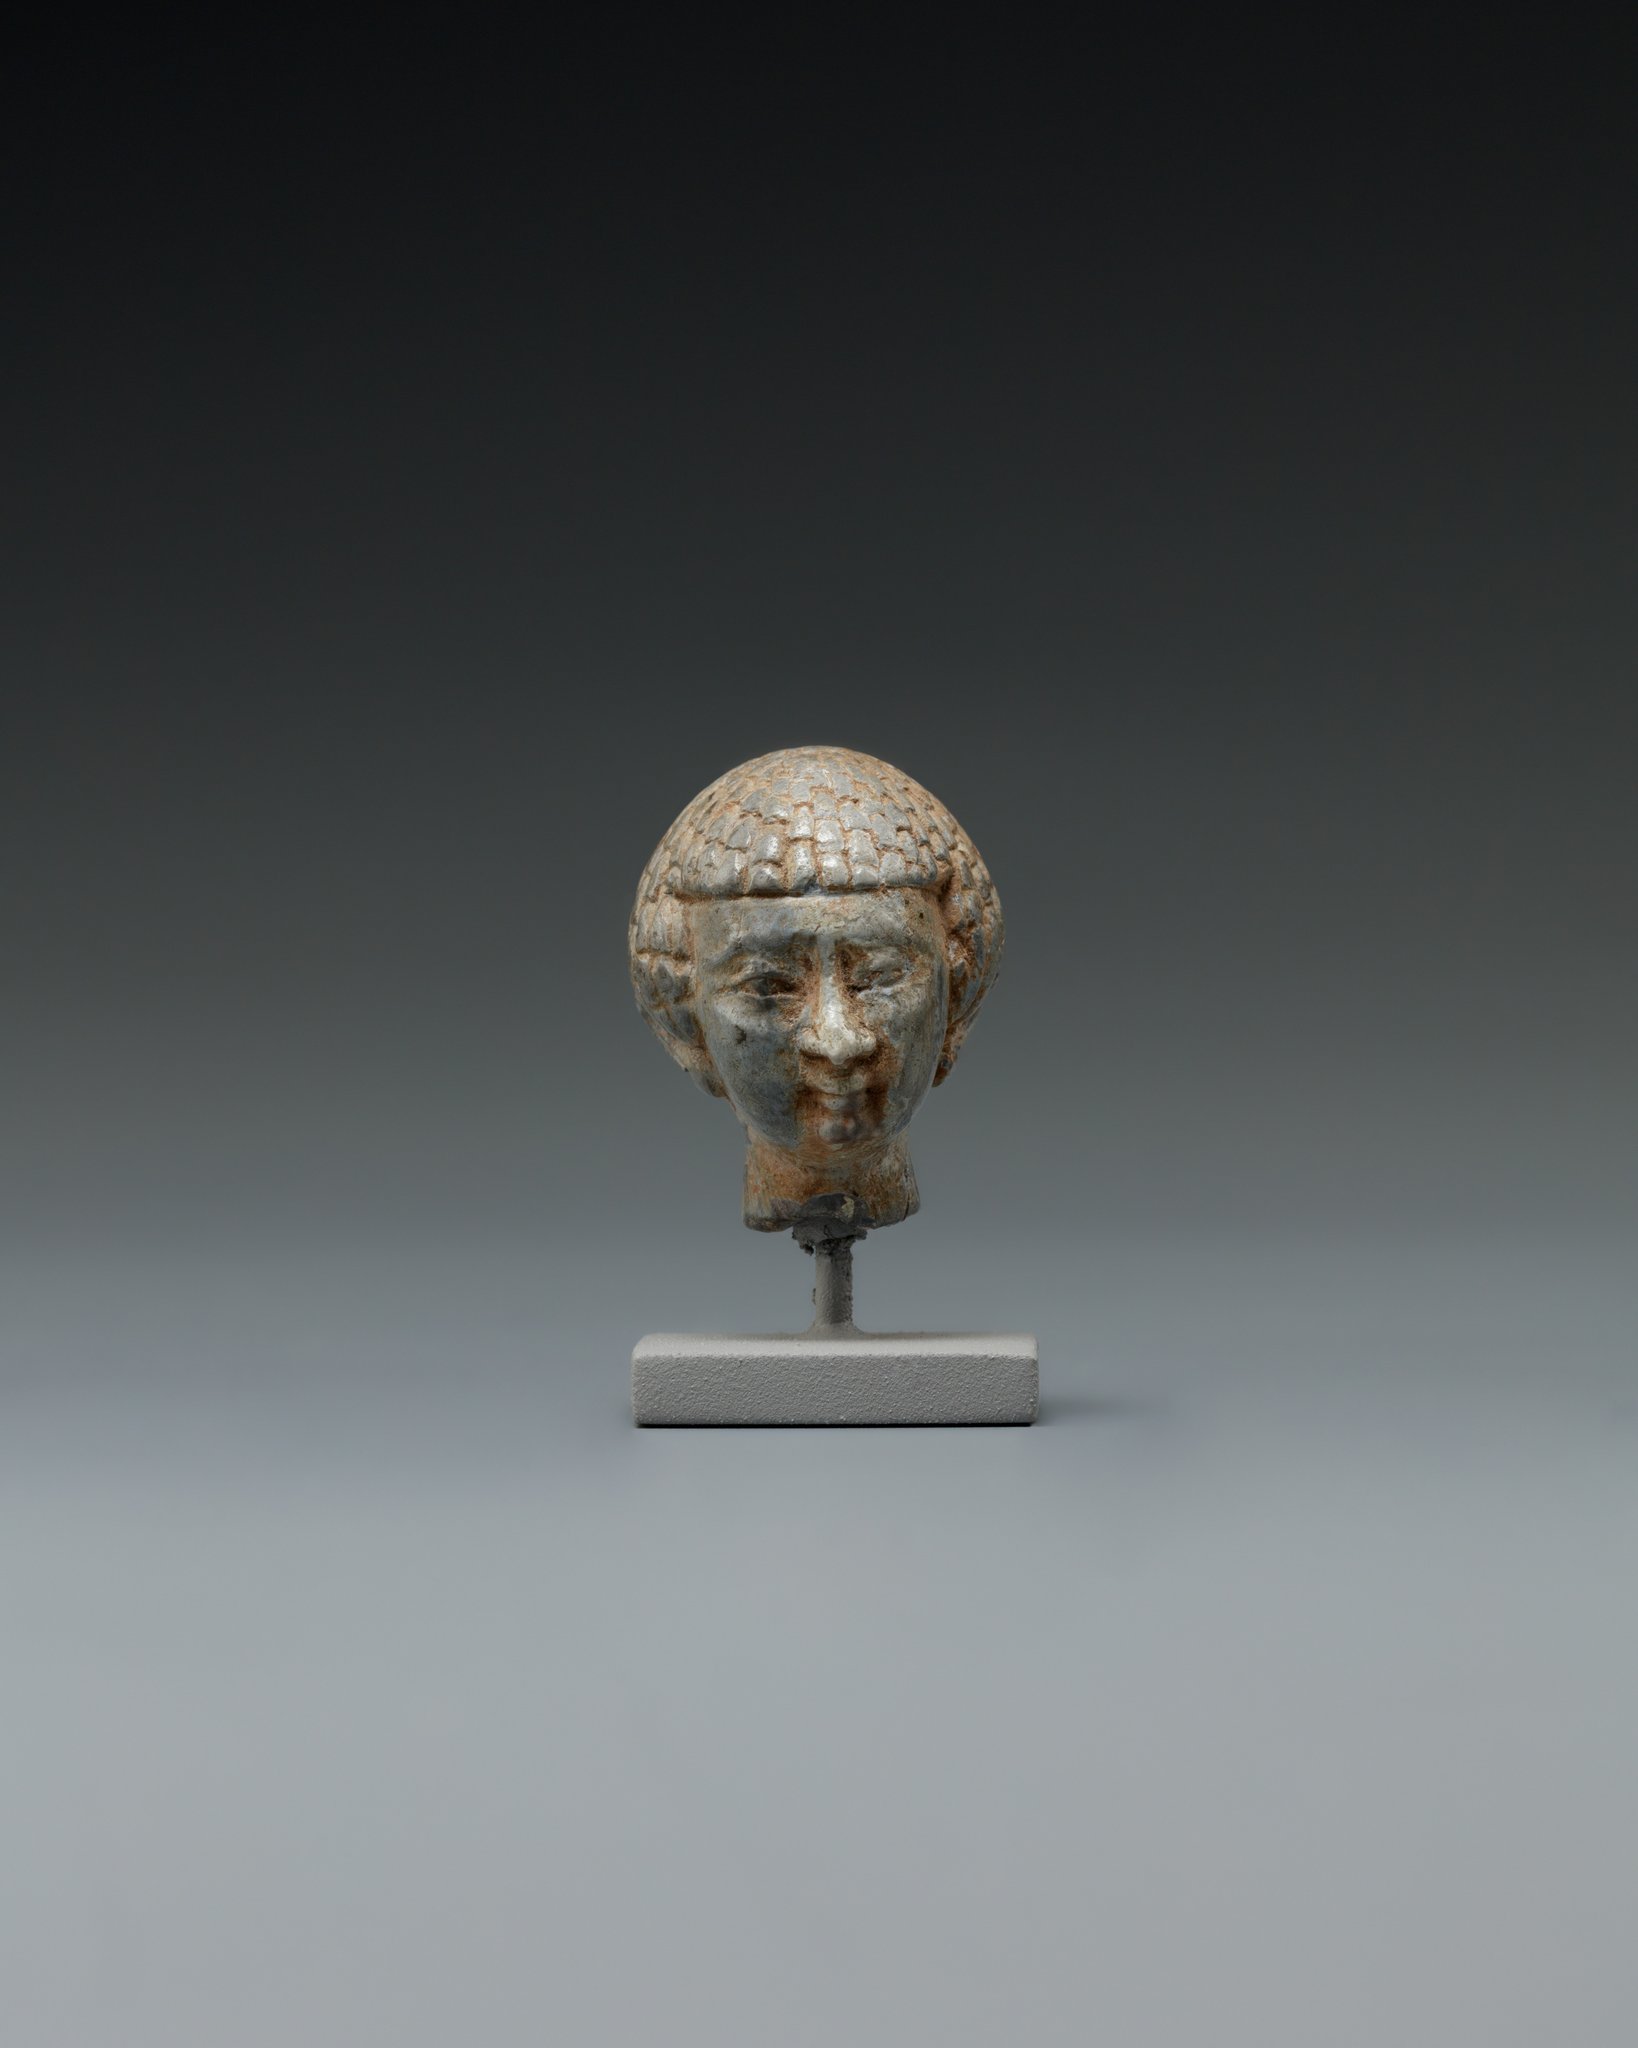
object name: head, female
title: Head from a Statuette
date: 664-332 BCE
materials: ivory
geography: egypt